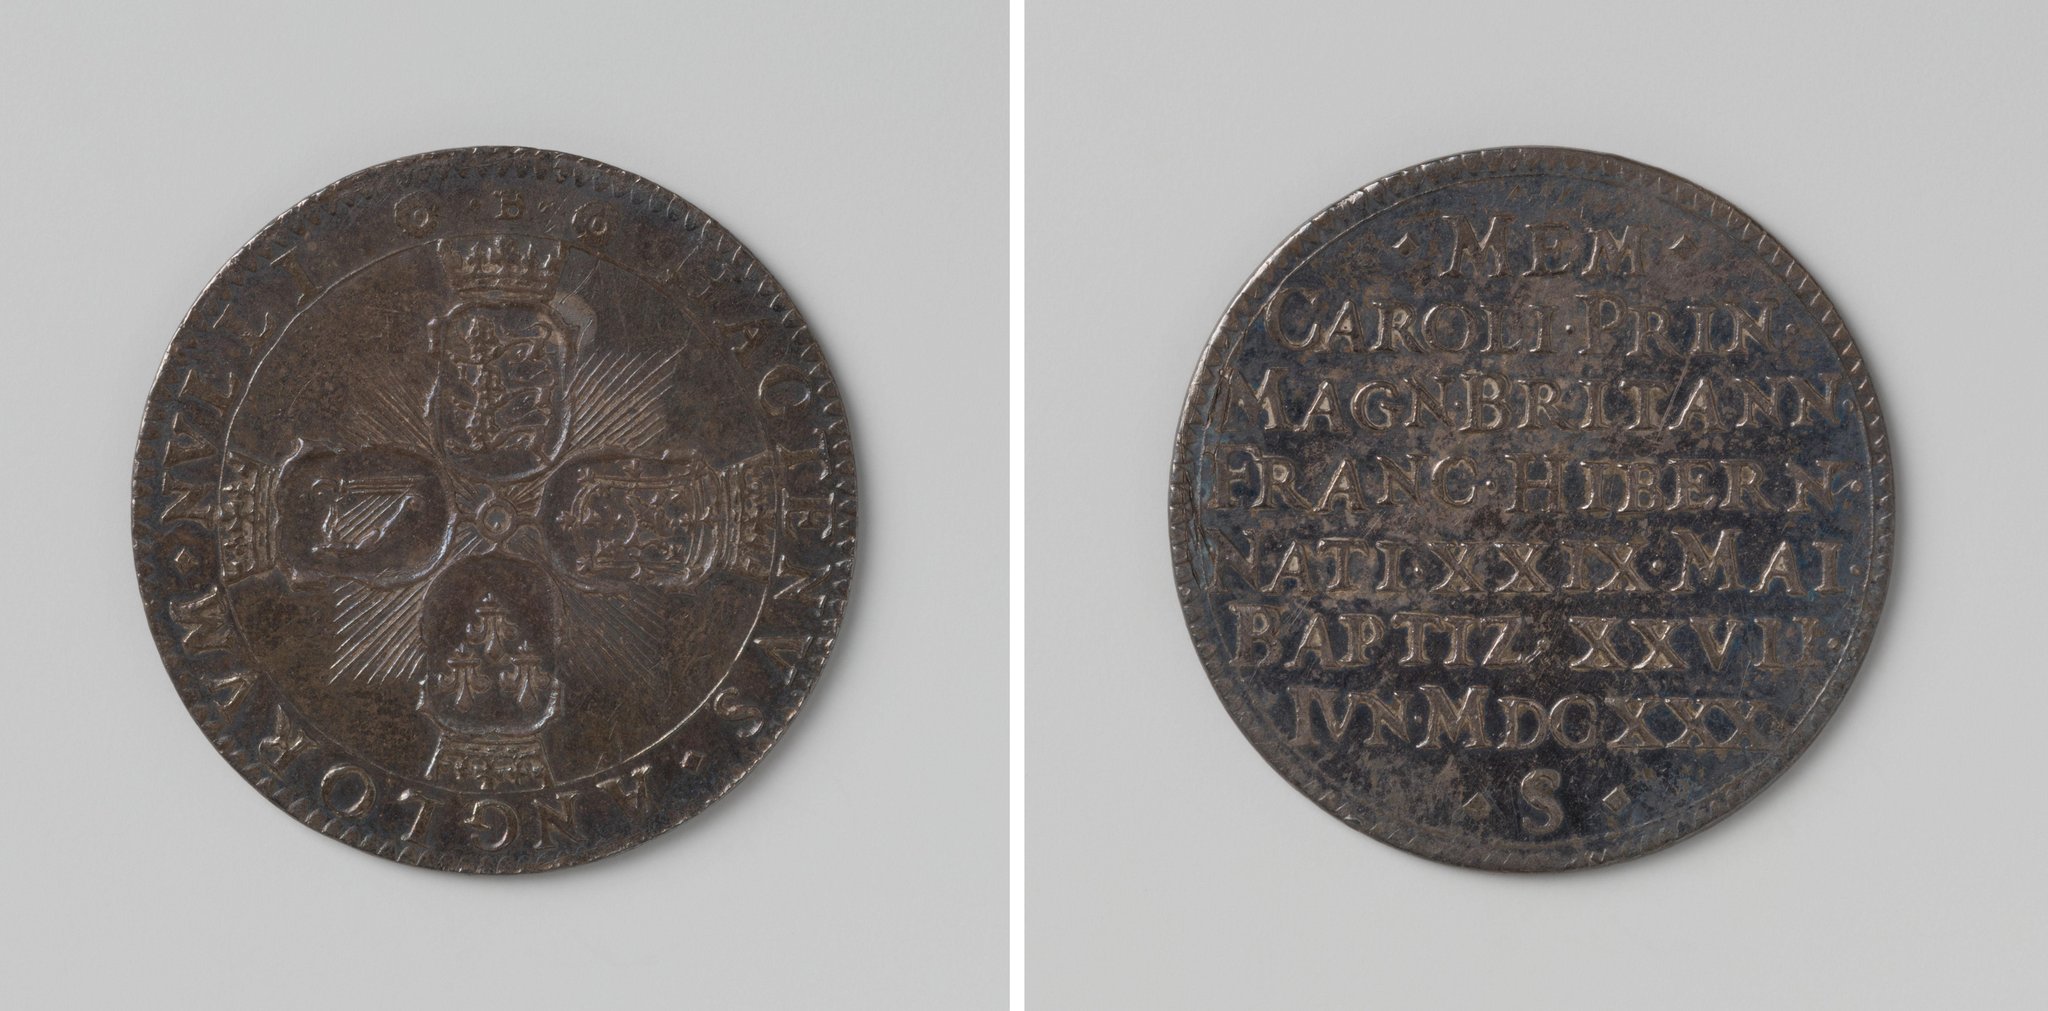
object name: jeton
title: Geboorte en doop van Karel, erfprins van Engeland, Schotland, Ierland en Frankrijk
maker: nicolas briot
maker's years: 1579-1646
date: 1630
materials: silver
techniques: striking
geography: london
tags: london, karel ii (koning van engeland)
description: Zilveren penning. Voorzijde: vier in kruis geplaatste, gekroonde wapenschilden in cartouche, bevestigd aan cirkel, waaruit zonnestralen te voorschijn komen binnen omschrift. Keerzijde: opschrift